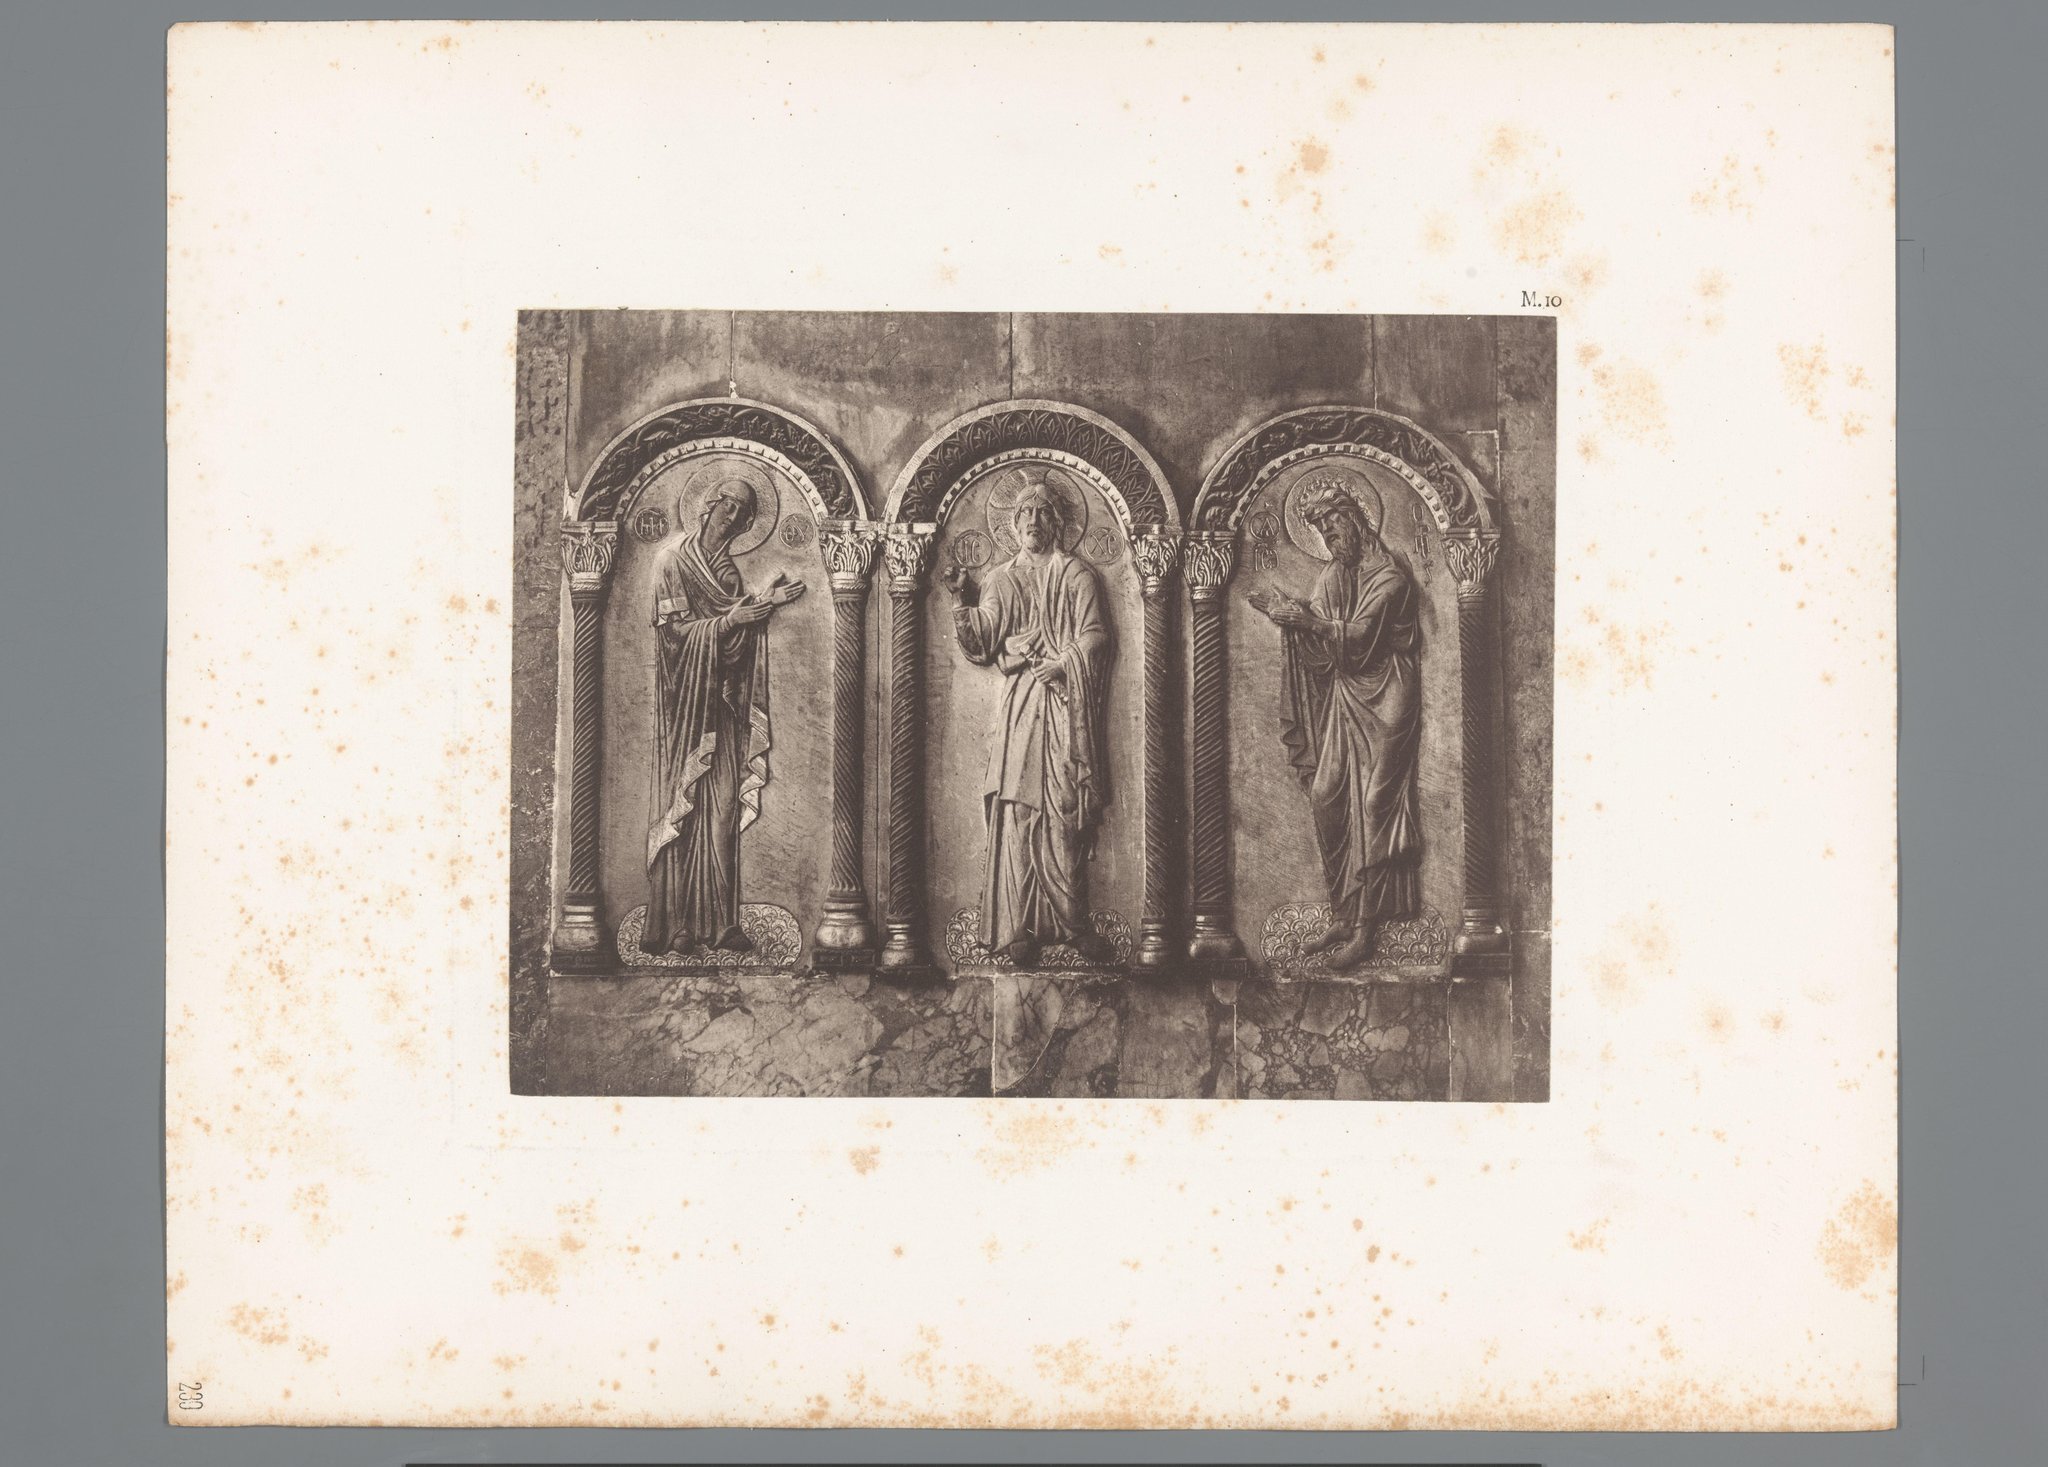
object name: photomechanical print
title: Reliëf van Maria, Christus en Johannes de Doper, van de San Marco in Venetië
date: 1880-1885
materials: paper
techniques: photograph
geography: st. mark's basilica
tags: mary (without the christ-child), john the baptist; possible attributes: book, reed cross, baptismal cup, honeycomb, lamb, staff, christ as adult, piece of sculpture, reproduction of a piece of sculpture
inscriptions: number: ‘M.10’, number: ‘239’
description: Deze prent maakt deel uit van een omslag met 79 prenten op 53 bladen en 2 tekstbladen.